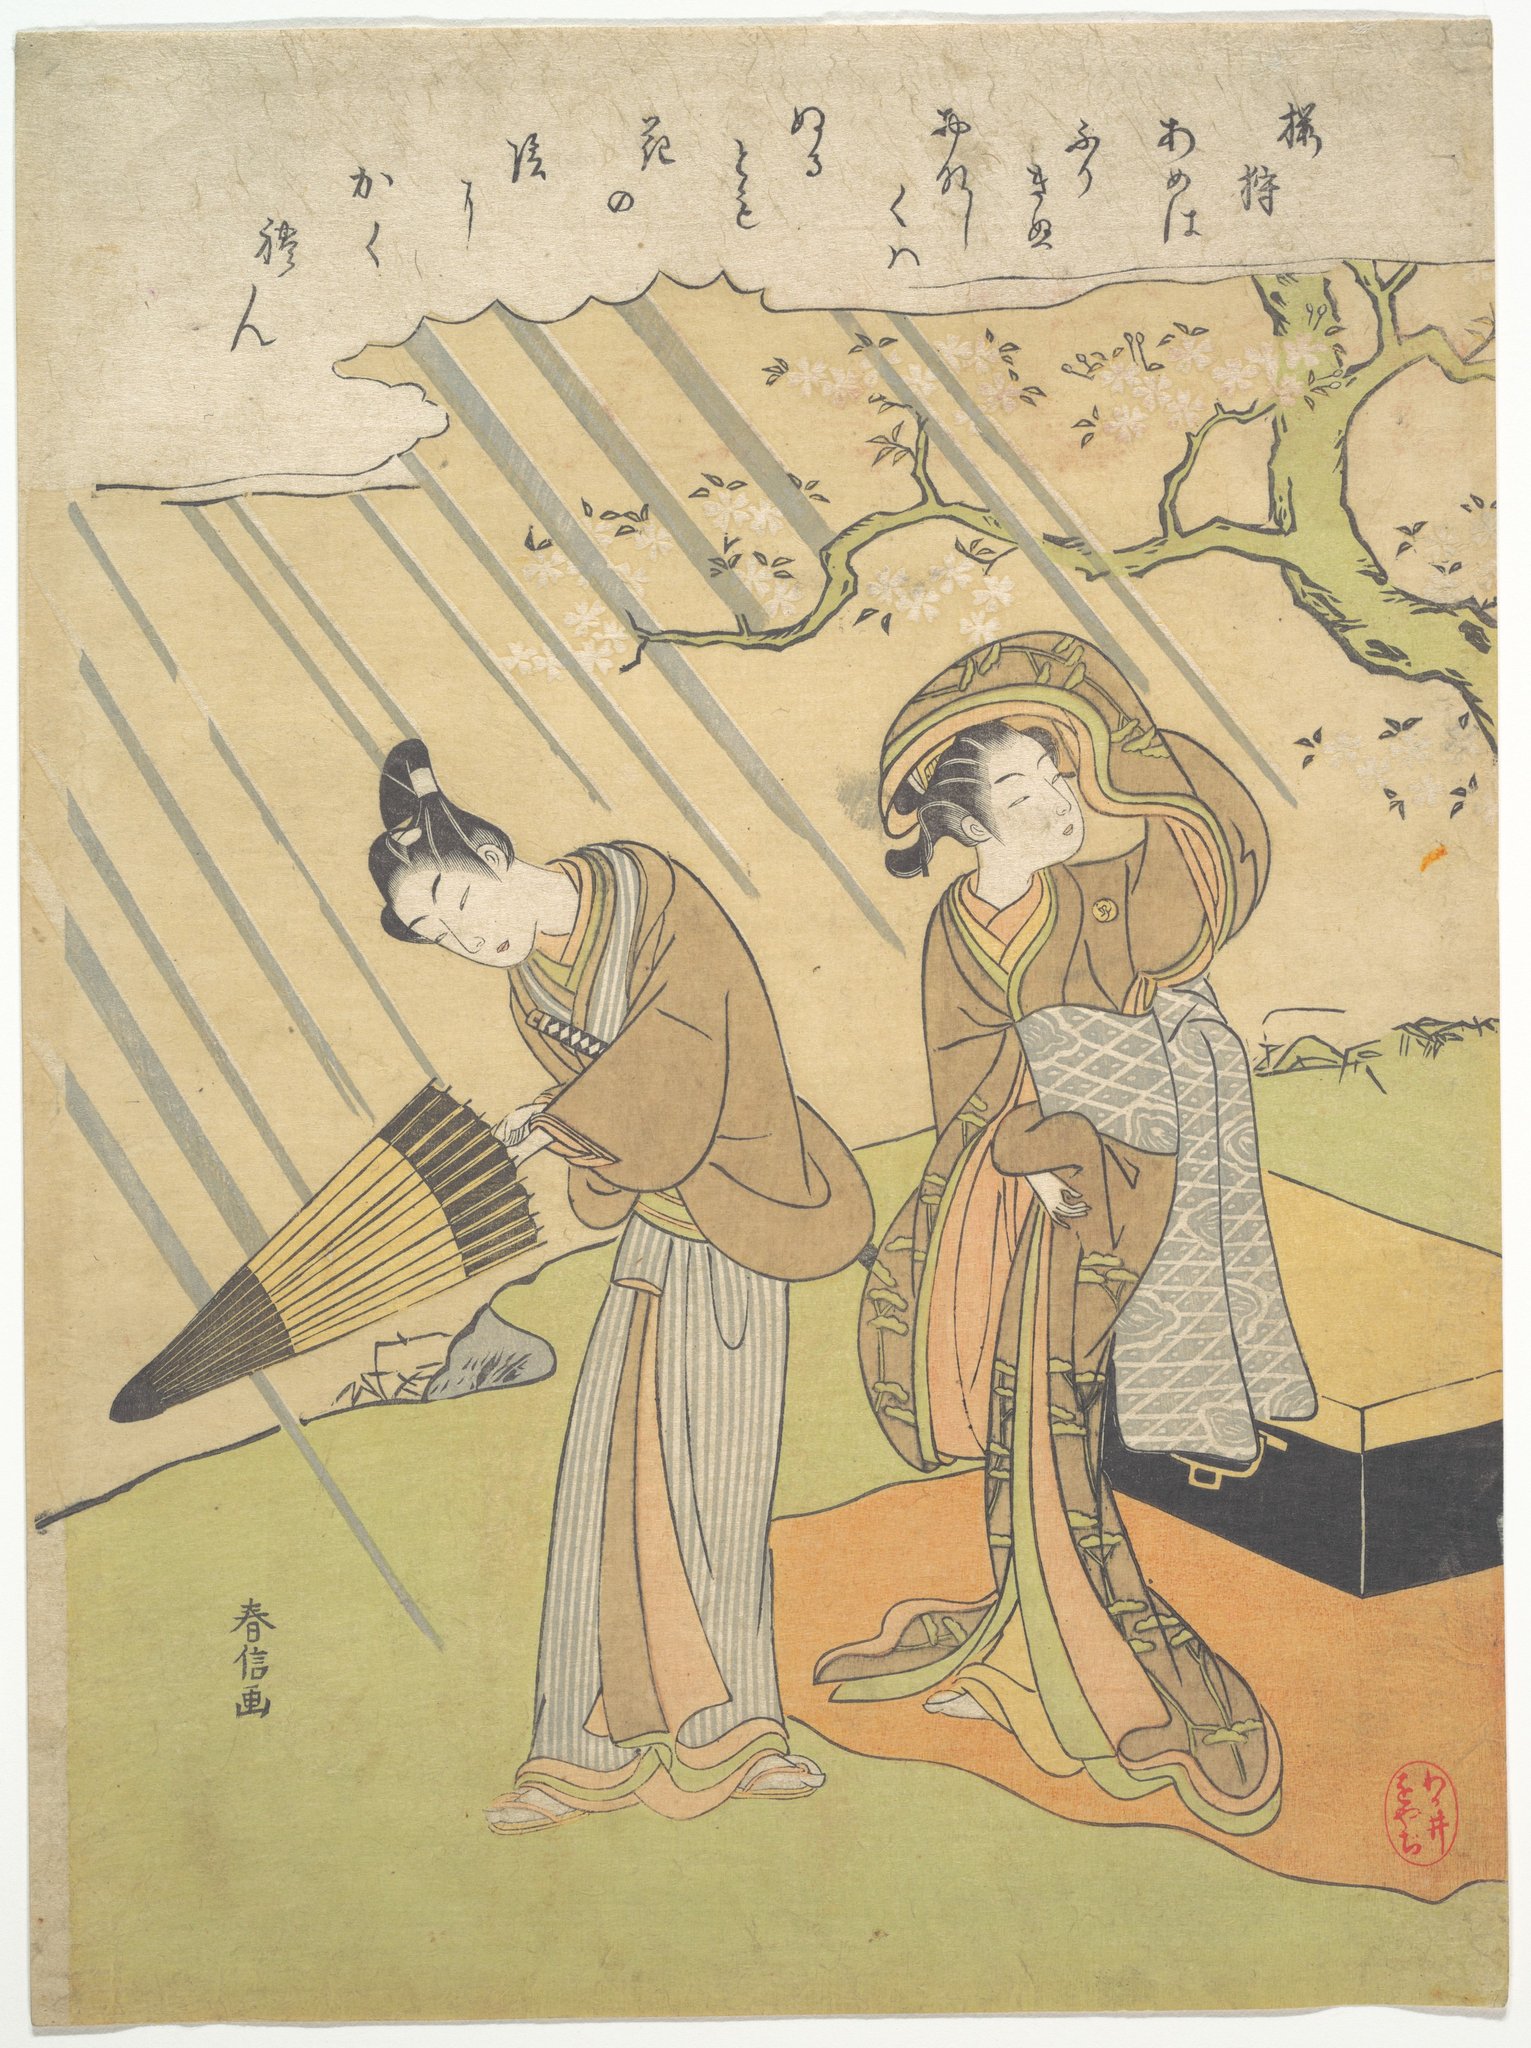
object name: print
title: Young Man and Woman Caught in the Rain while Enjoying Cherry Blossoms (Sakura-gari)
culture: japanese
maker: suzuki harunobu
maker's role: artist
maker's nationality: japanese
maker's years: 1725-1770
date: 1768-1770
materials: ink, paper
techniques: woodblock print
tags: men,women,trees,rain